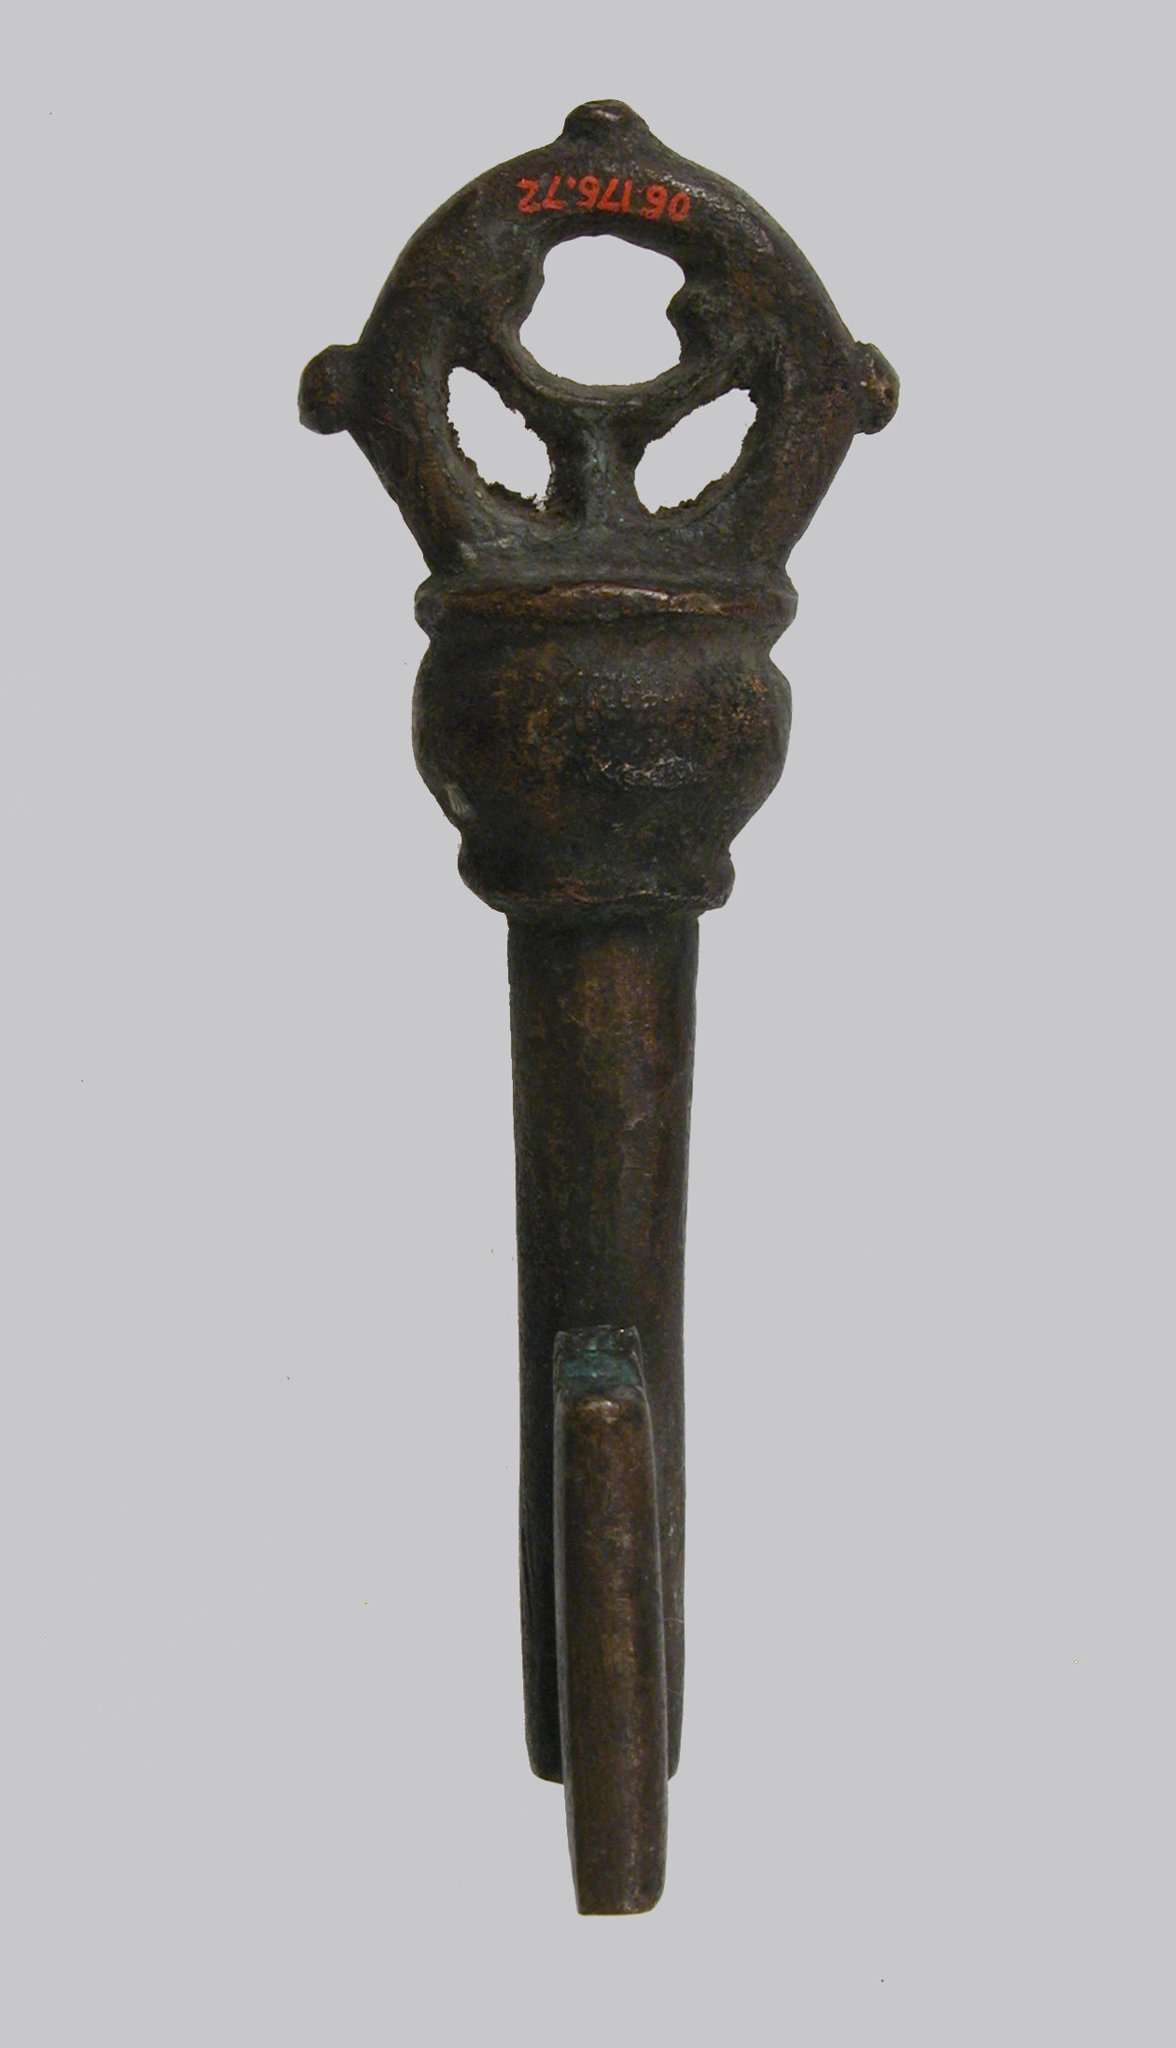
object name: key handle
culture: roman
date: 1-700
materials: copper alloy